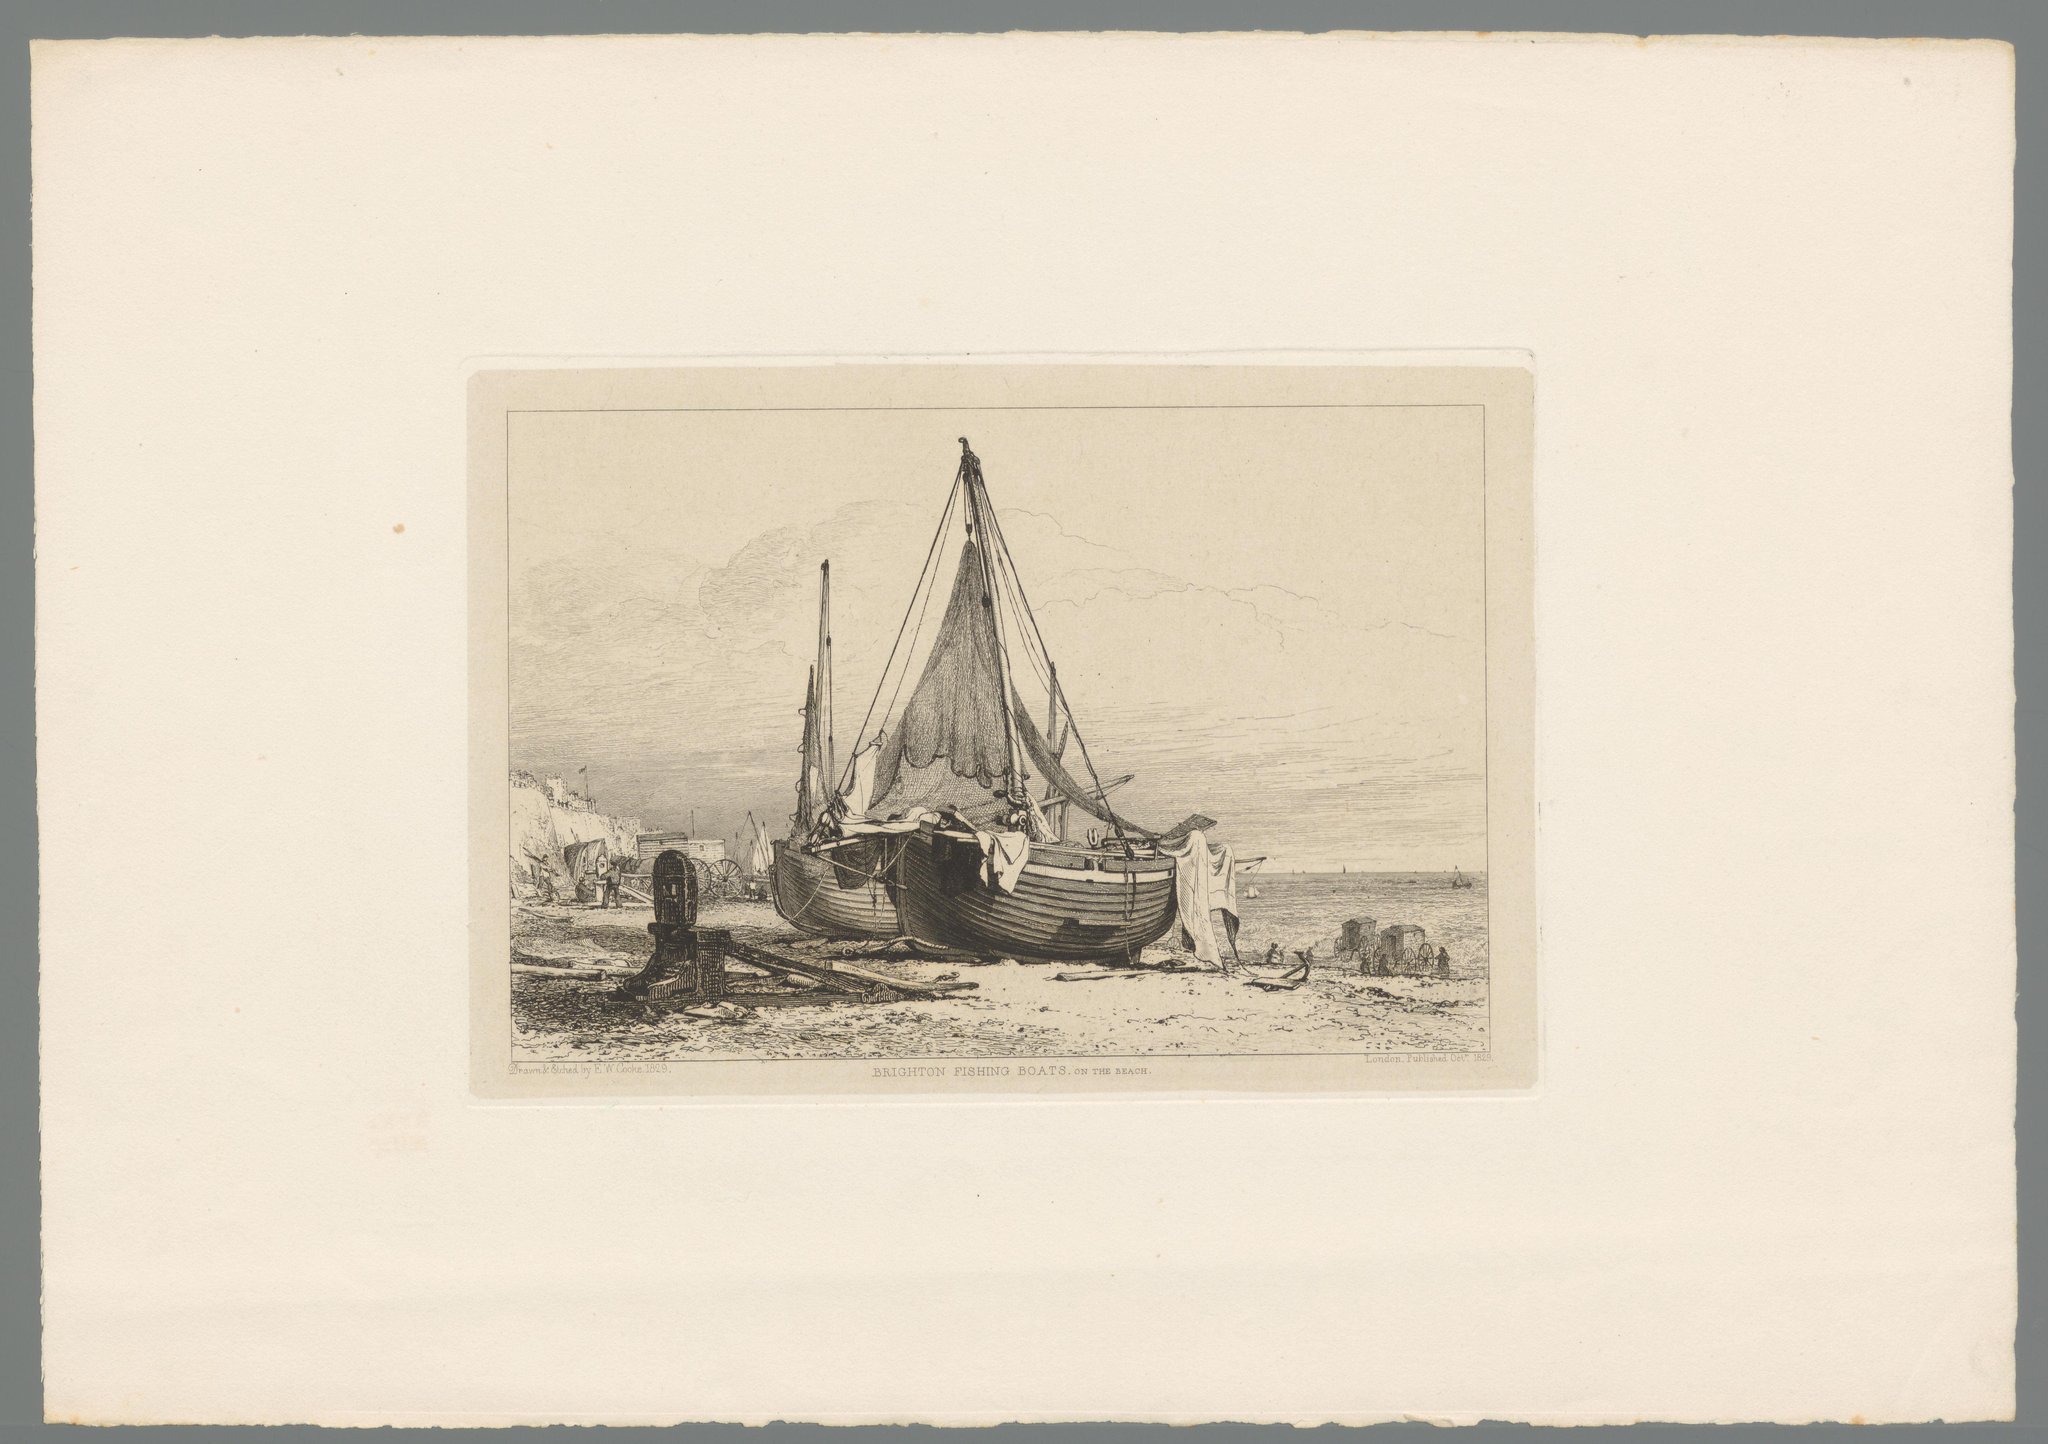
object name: print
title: Twee boten met vissersnet hangend aan de mast op het strand van Brighton, op de achtergrond huifkarren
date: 1810-1829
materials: paper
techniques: etching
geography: london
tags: sailing-ship, sailing-boat, fishing net, four-wheeled, animal-drawn vehicle, e.g.: cab, carriage, coach, beach (+ landscape with figures, staffage)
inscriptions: collector's mark: Lugt 2165